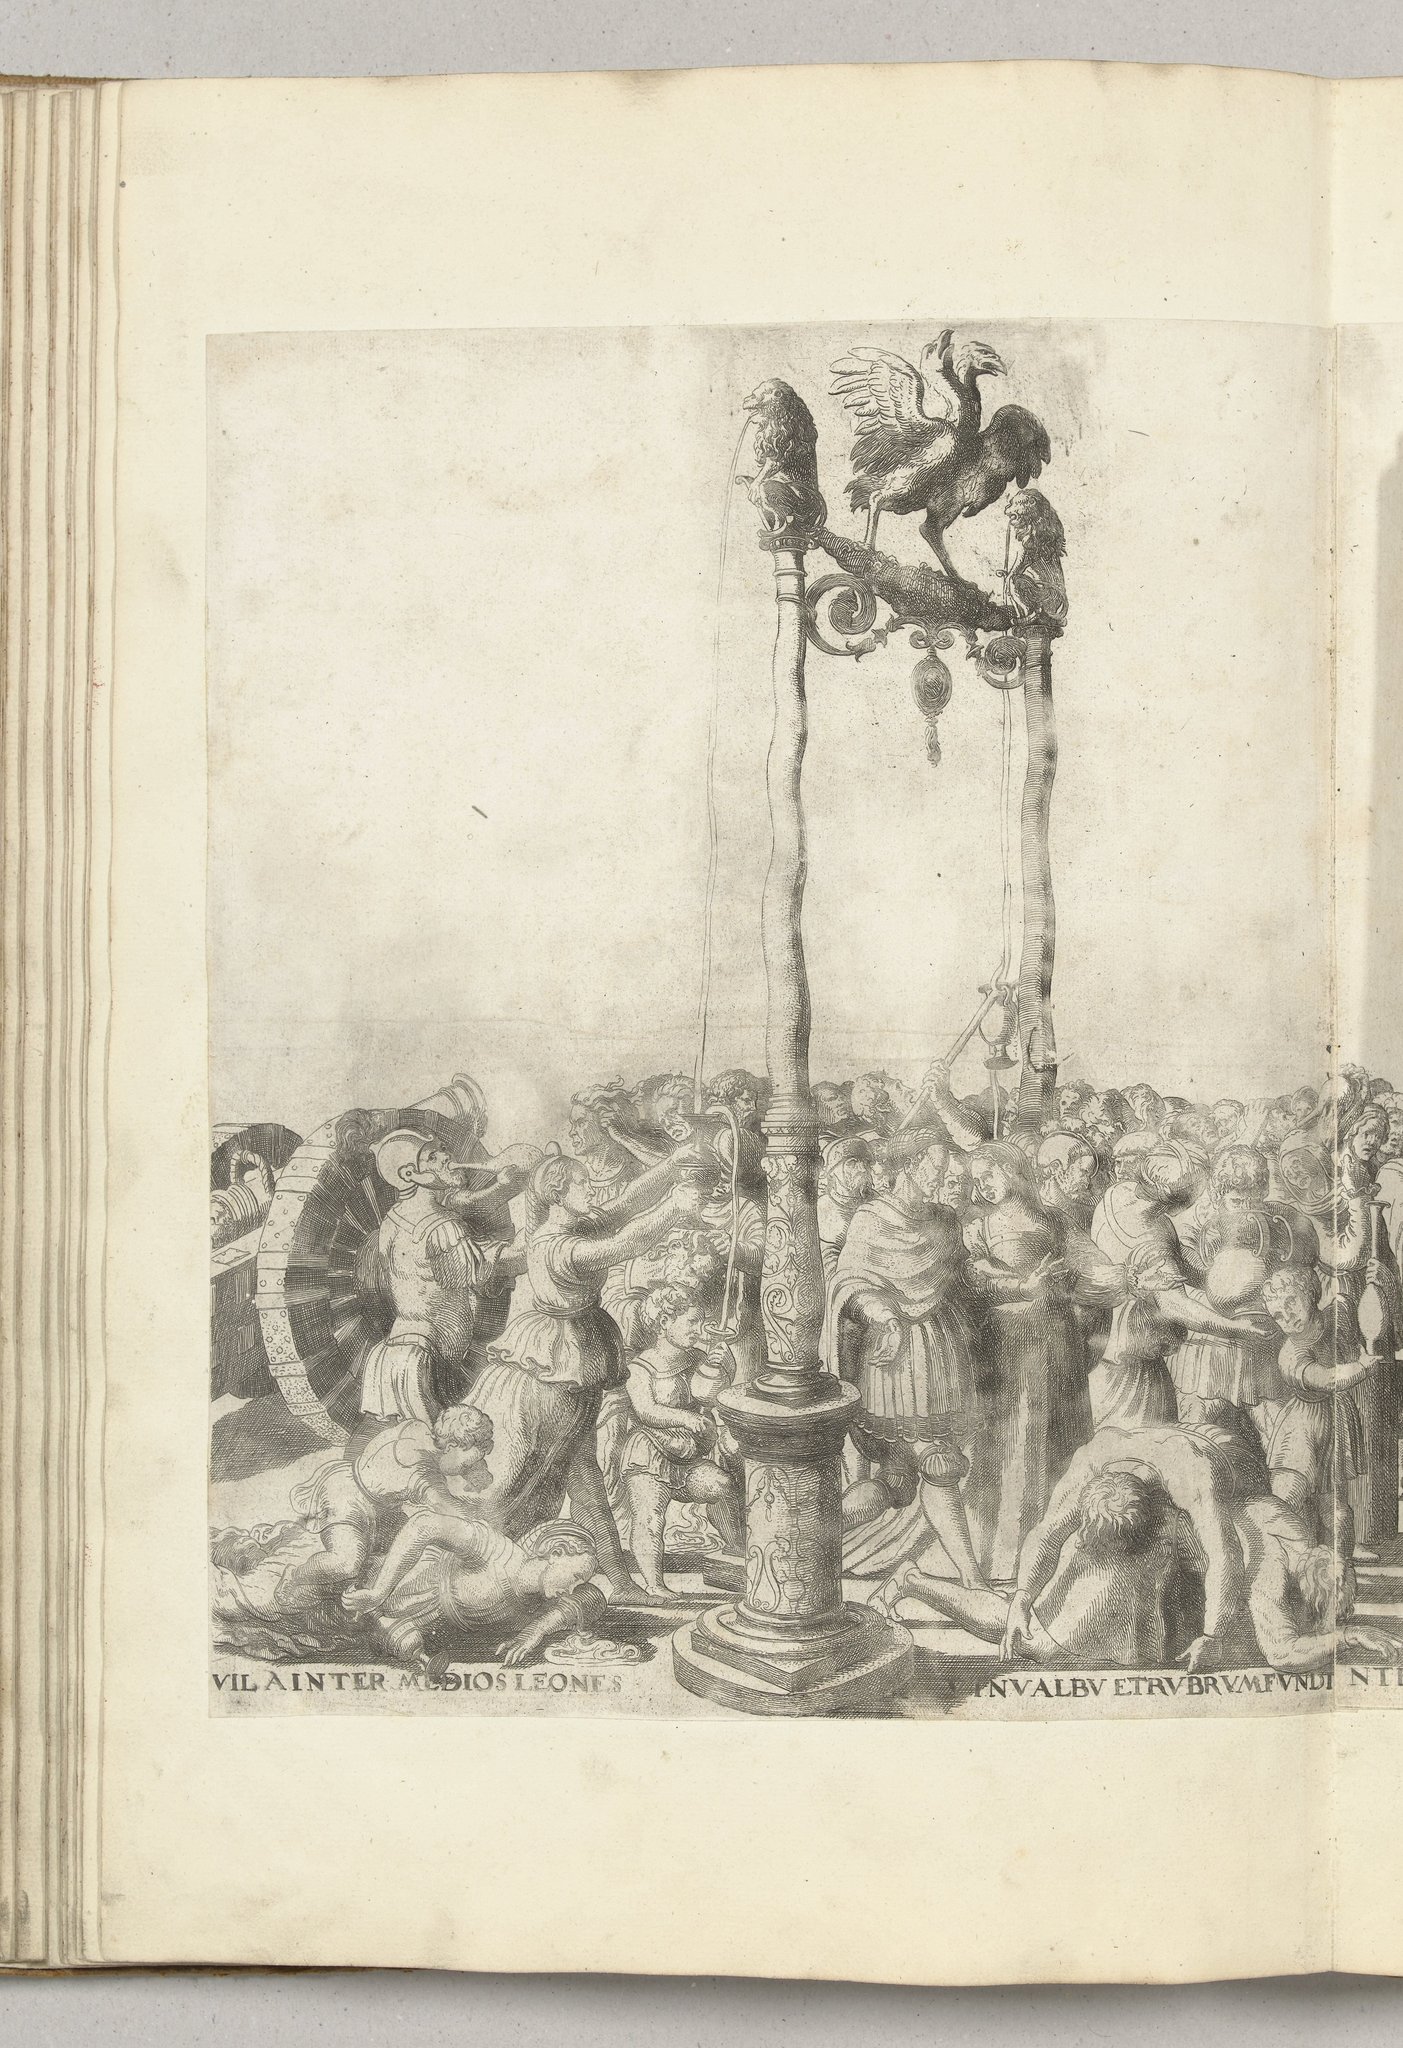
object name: print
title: Optocht van Karel V met de paus te Bologna na zijn kroning to keizer, 1530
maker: nicolaas hogenberg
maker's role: draughtsman, painter, print maker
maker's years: 1500-1539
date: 1530-1536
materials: paper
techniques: etching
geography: mechelen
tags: ghent, charles v (holy roman emperor and king of spain), rome, drunkard, festivities (+ parade, pageant, cavalcade ~ festive activities)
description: Prent in het album waarin zijn ingeplakt de 40 platen die achterelkaar samen het fries vormen van de optocht van Karel V met de paus Clemens VII te Bologna na zijn kroning tot keizer, 24 februari 1530.